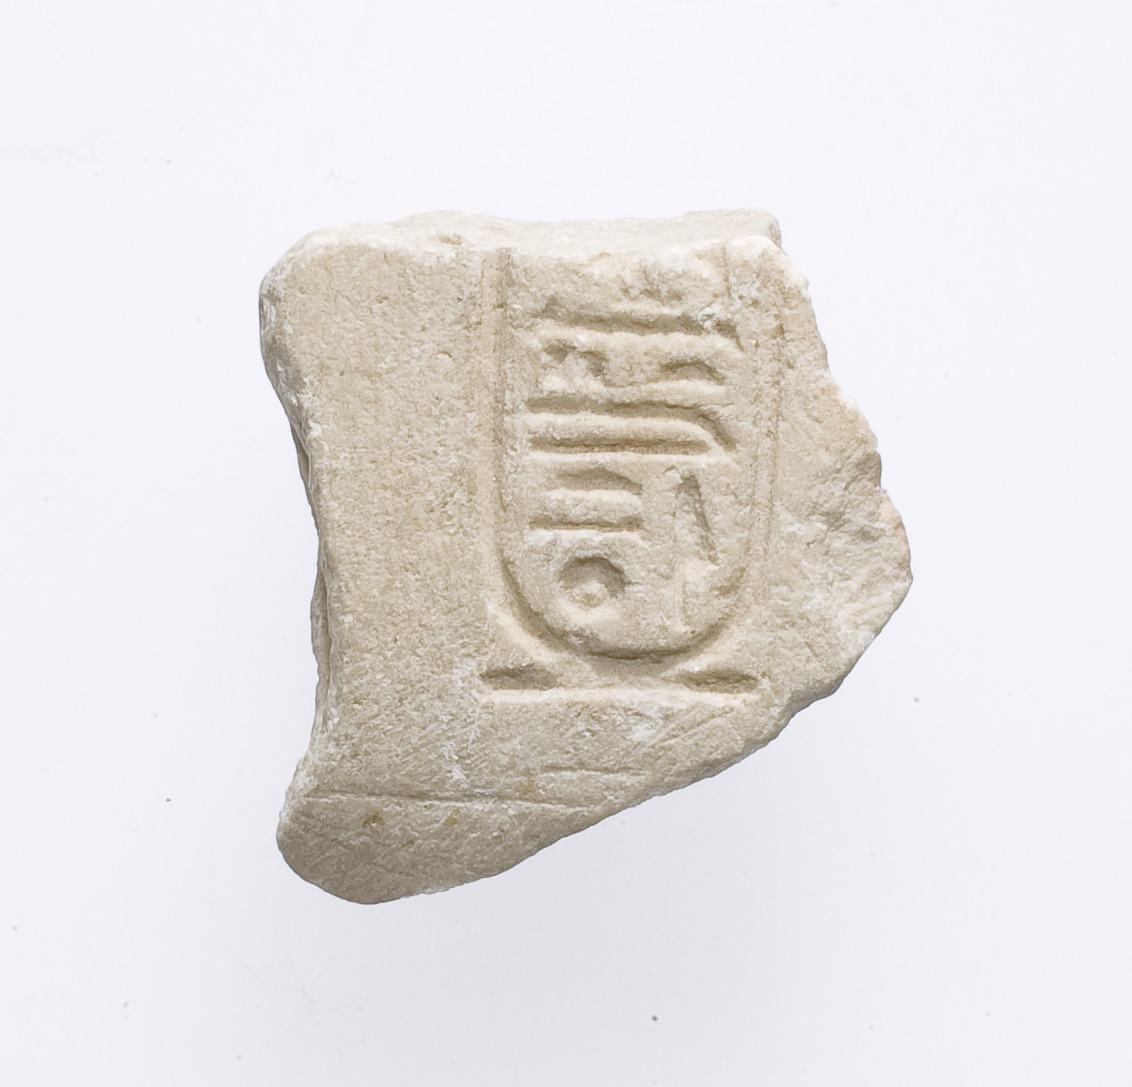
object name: cobra, hood, aten cartouche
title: Cobra, Hood (?), Aten cartouche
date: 1353-1336 BCE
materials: limestone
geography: egypt